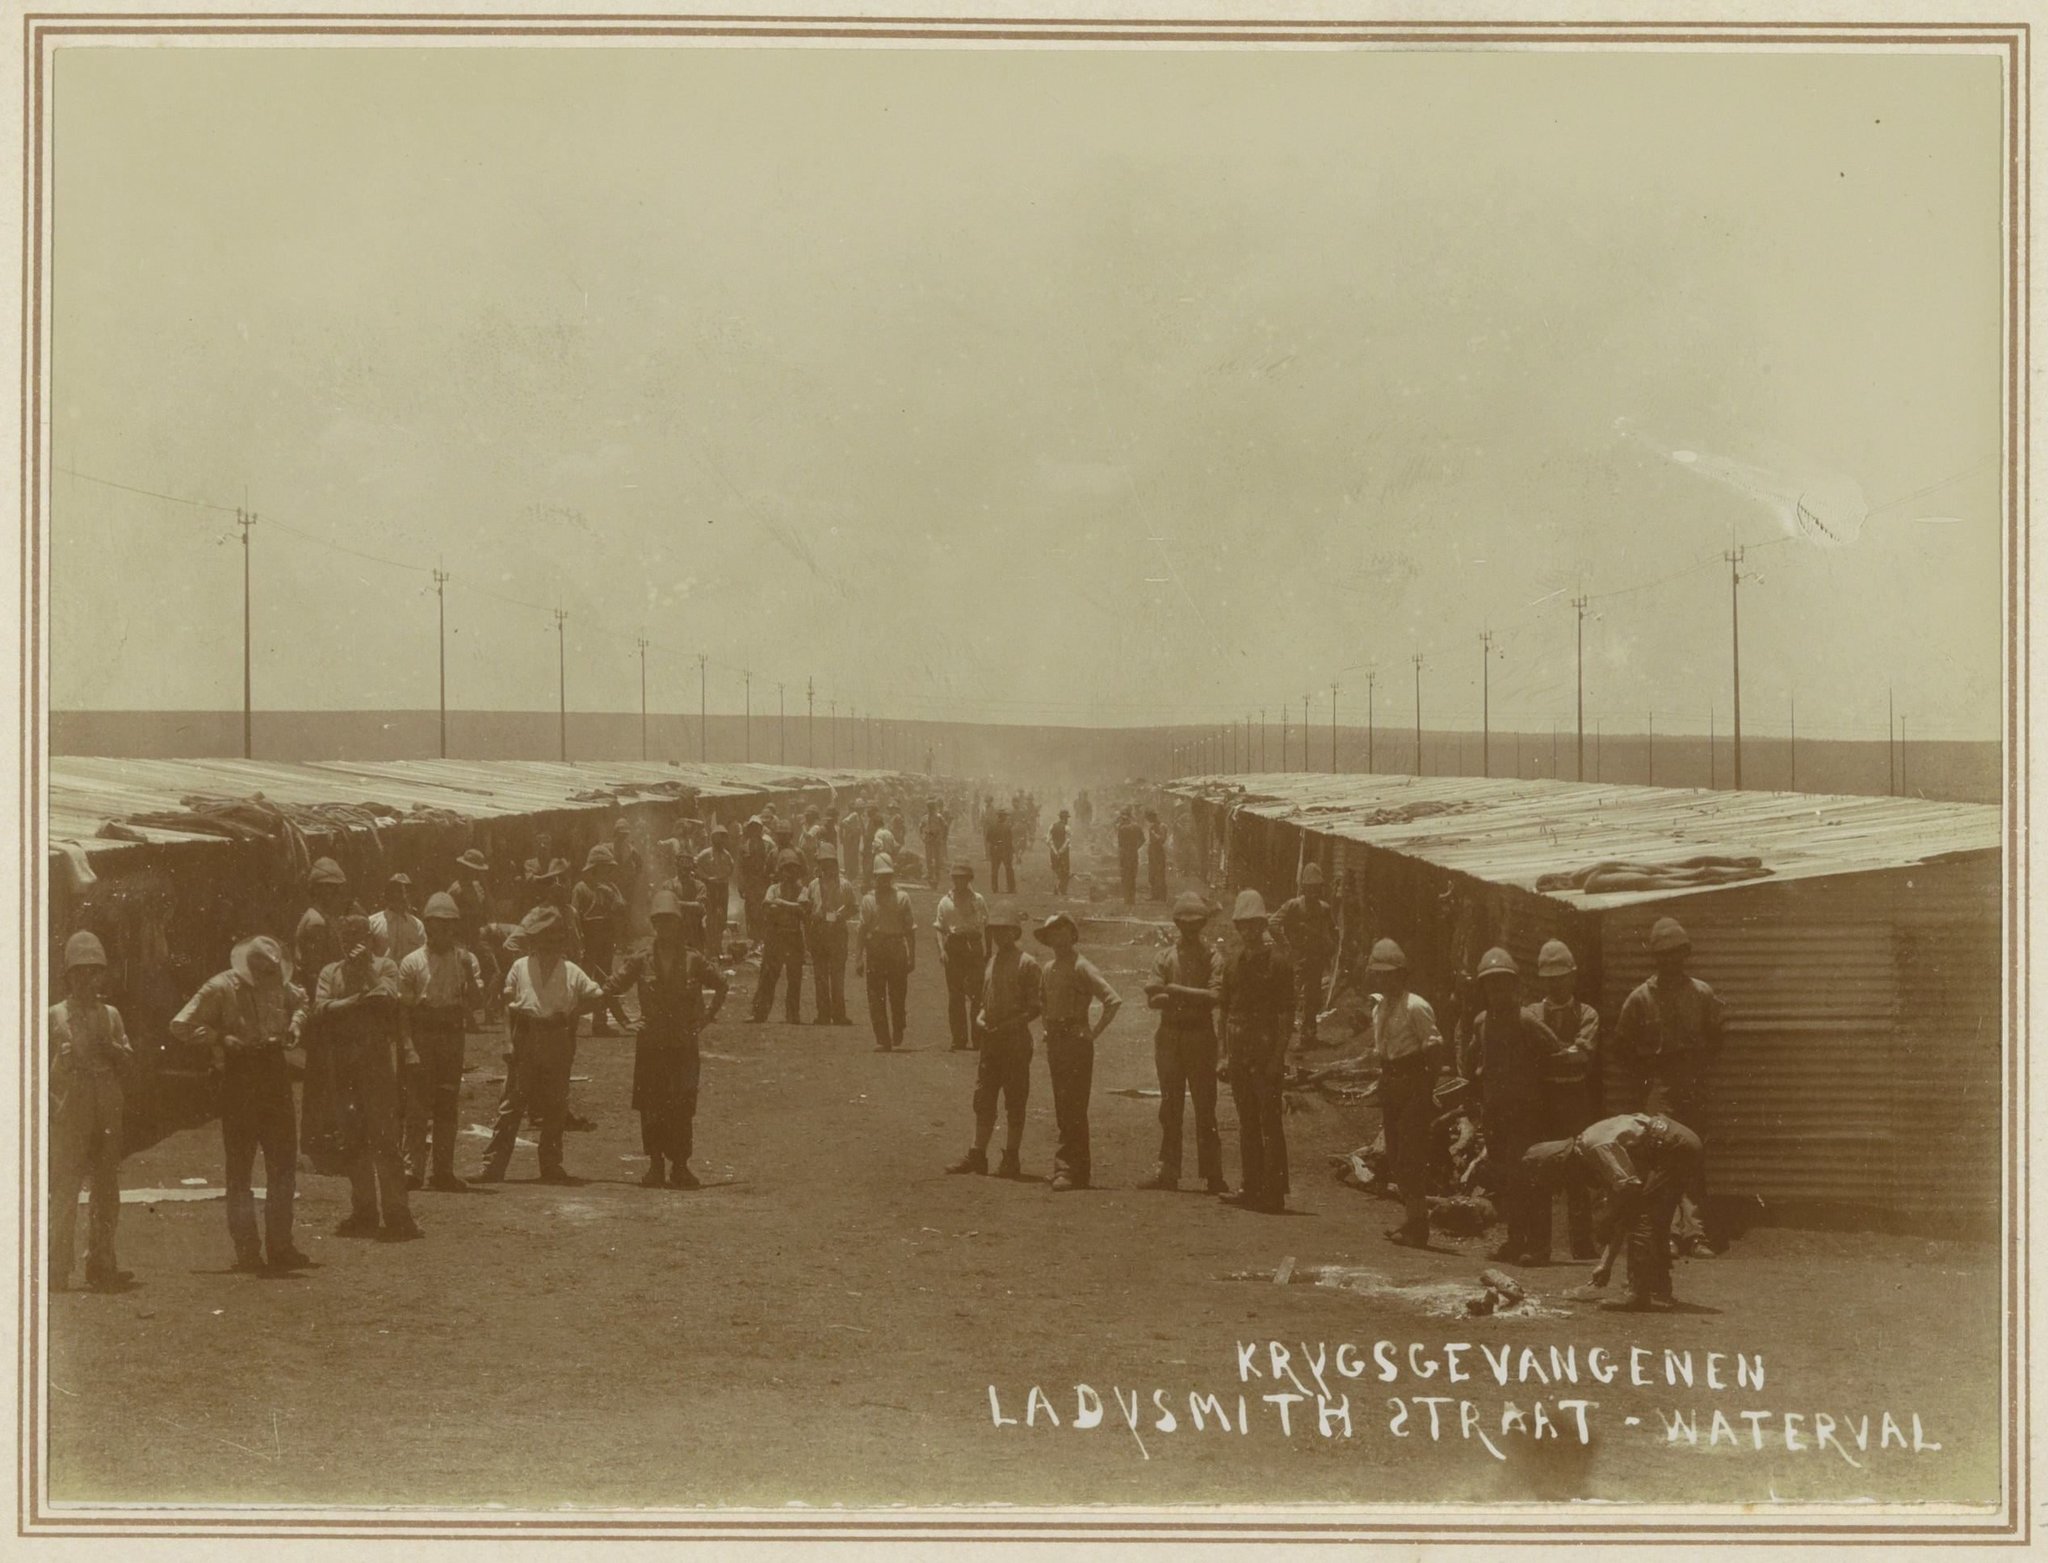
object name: photograph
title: Krijgsgevangenen Ladysmith Straat - Waterval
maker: Anonymous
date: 1899-1900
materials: cardboard, paper, photographic support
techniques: gelatin silver print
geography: south africa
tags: (military) camp with tents, prisoner of war (after the battle)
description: Onderdeel van Fotoalbum met opnames van de Tweede Boerenoorlog (1899-1902).